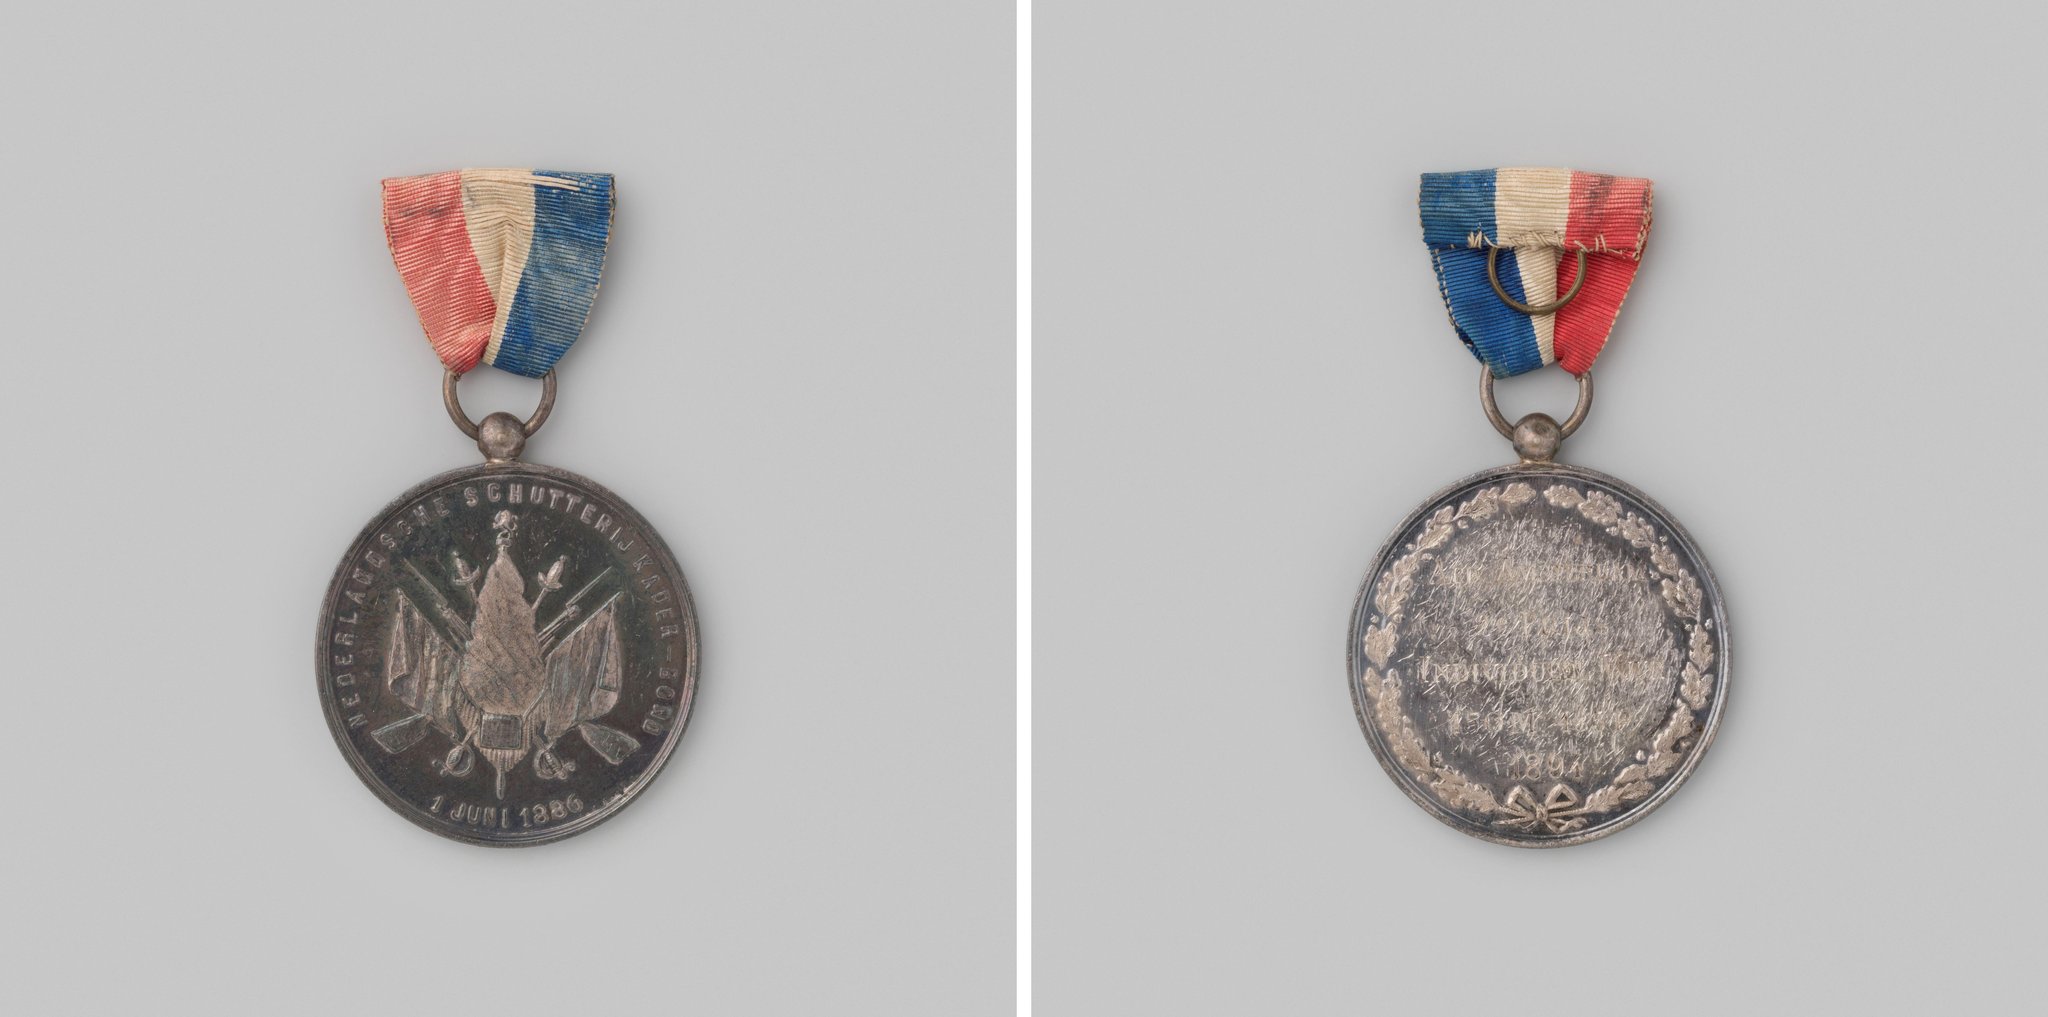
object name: draagpenning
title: Prijspenning van de Nederlandsche Schutterij Kaderbond, 1894, behaald door de afdeling Amsterdam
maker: Anonymous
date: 1894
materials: silver, textile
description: Zilveren draagpenning met knop, ring en lint